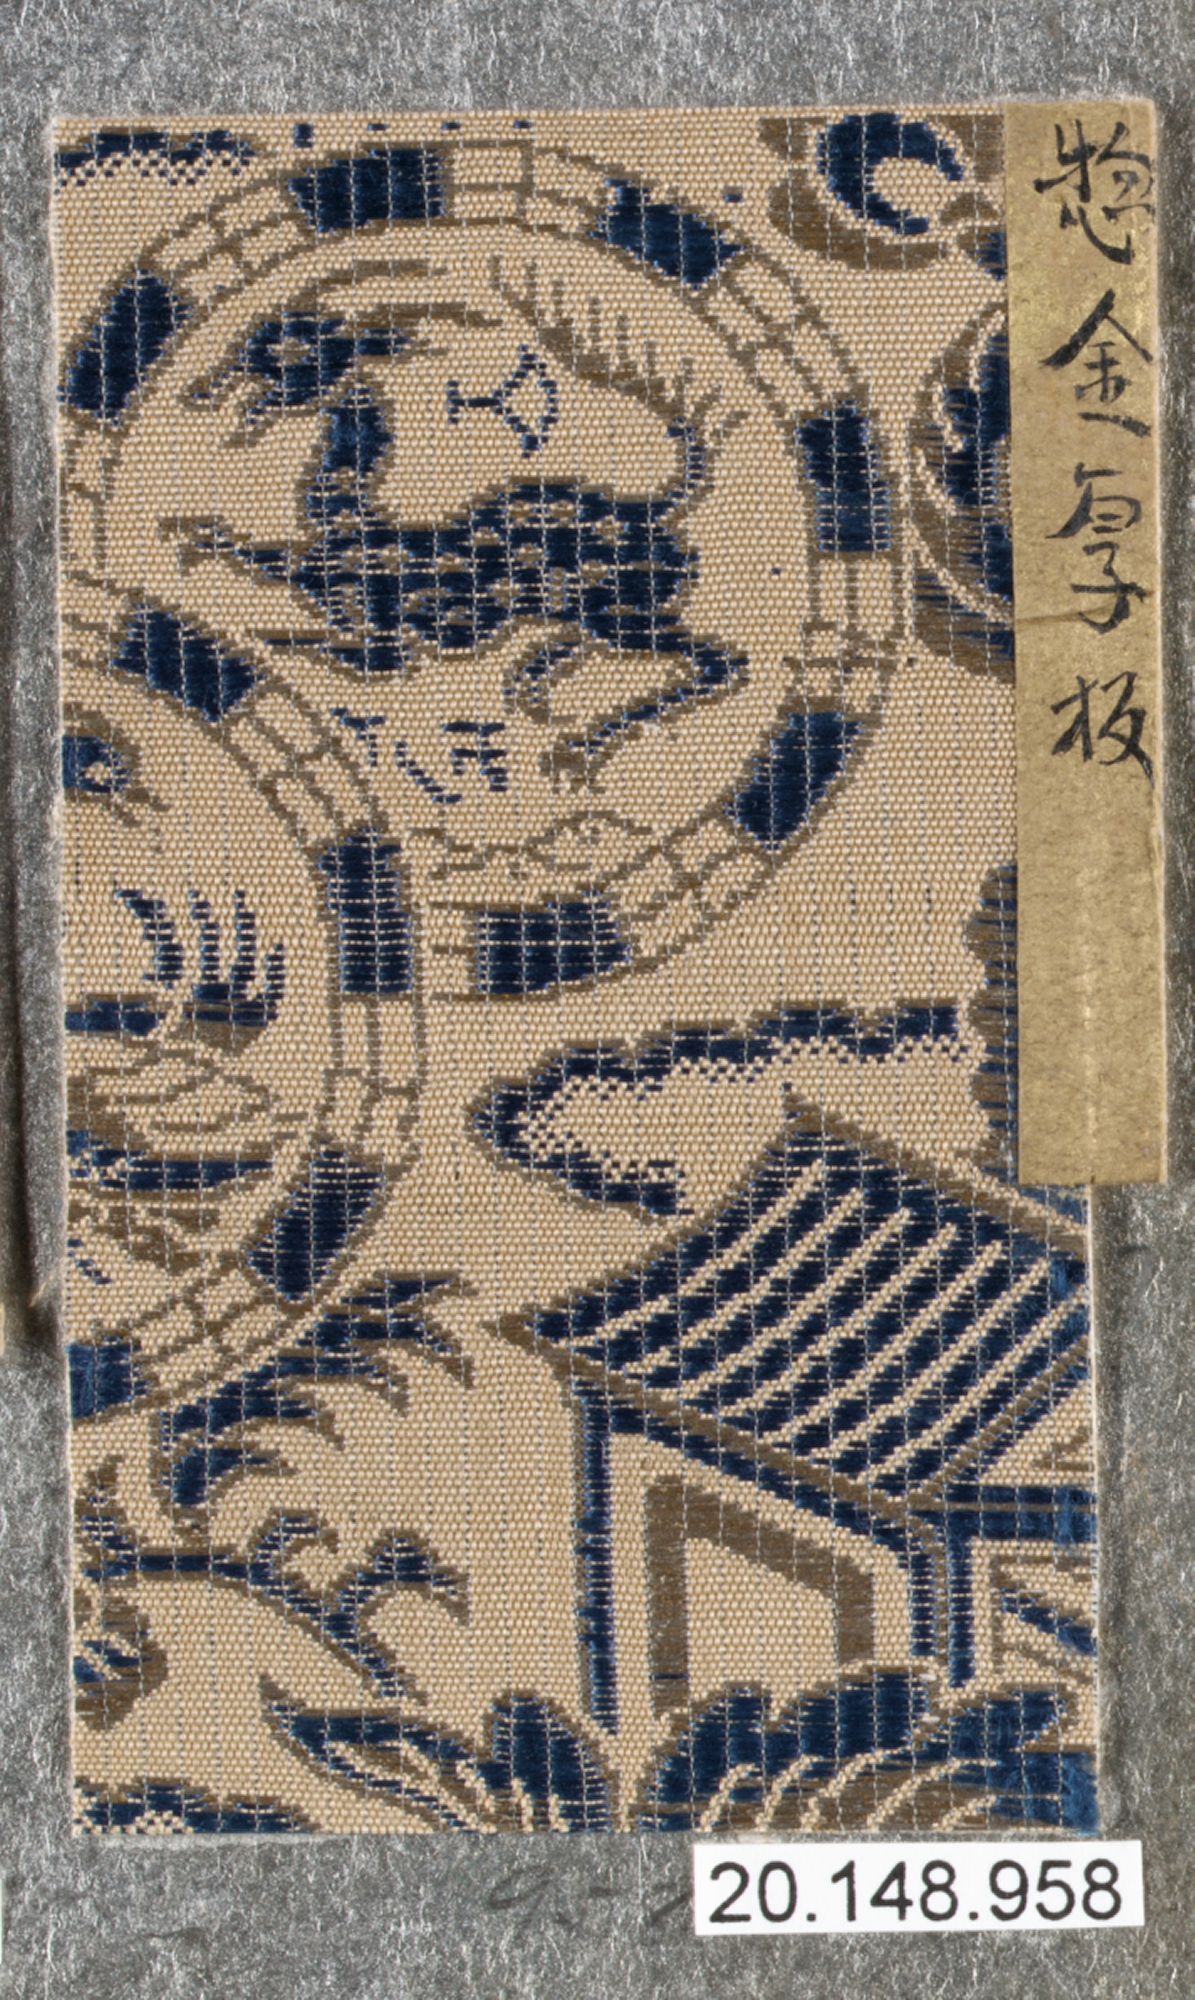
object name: piece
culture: japanese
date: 1701-1800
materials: silk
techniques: compound weave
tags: animals,houses